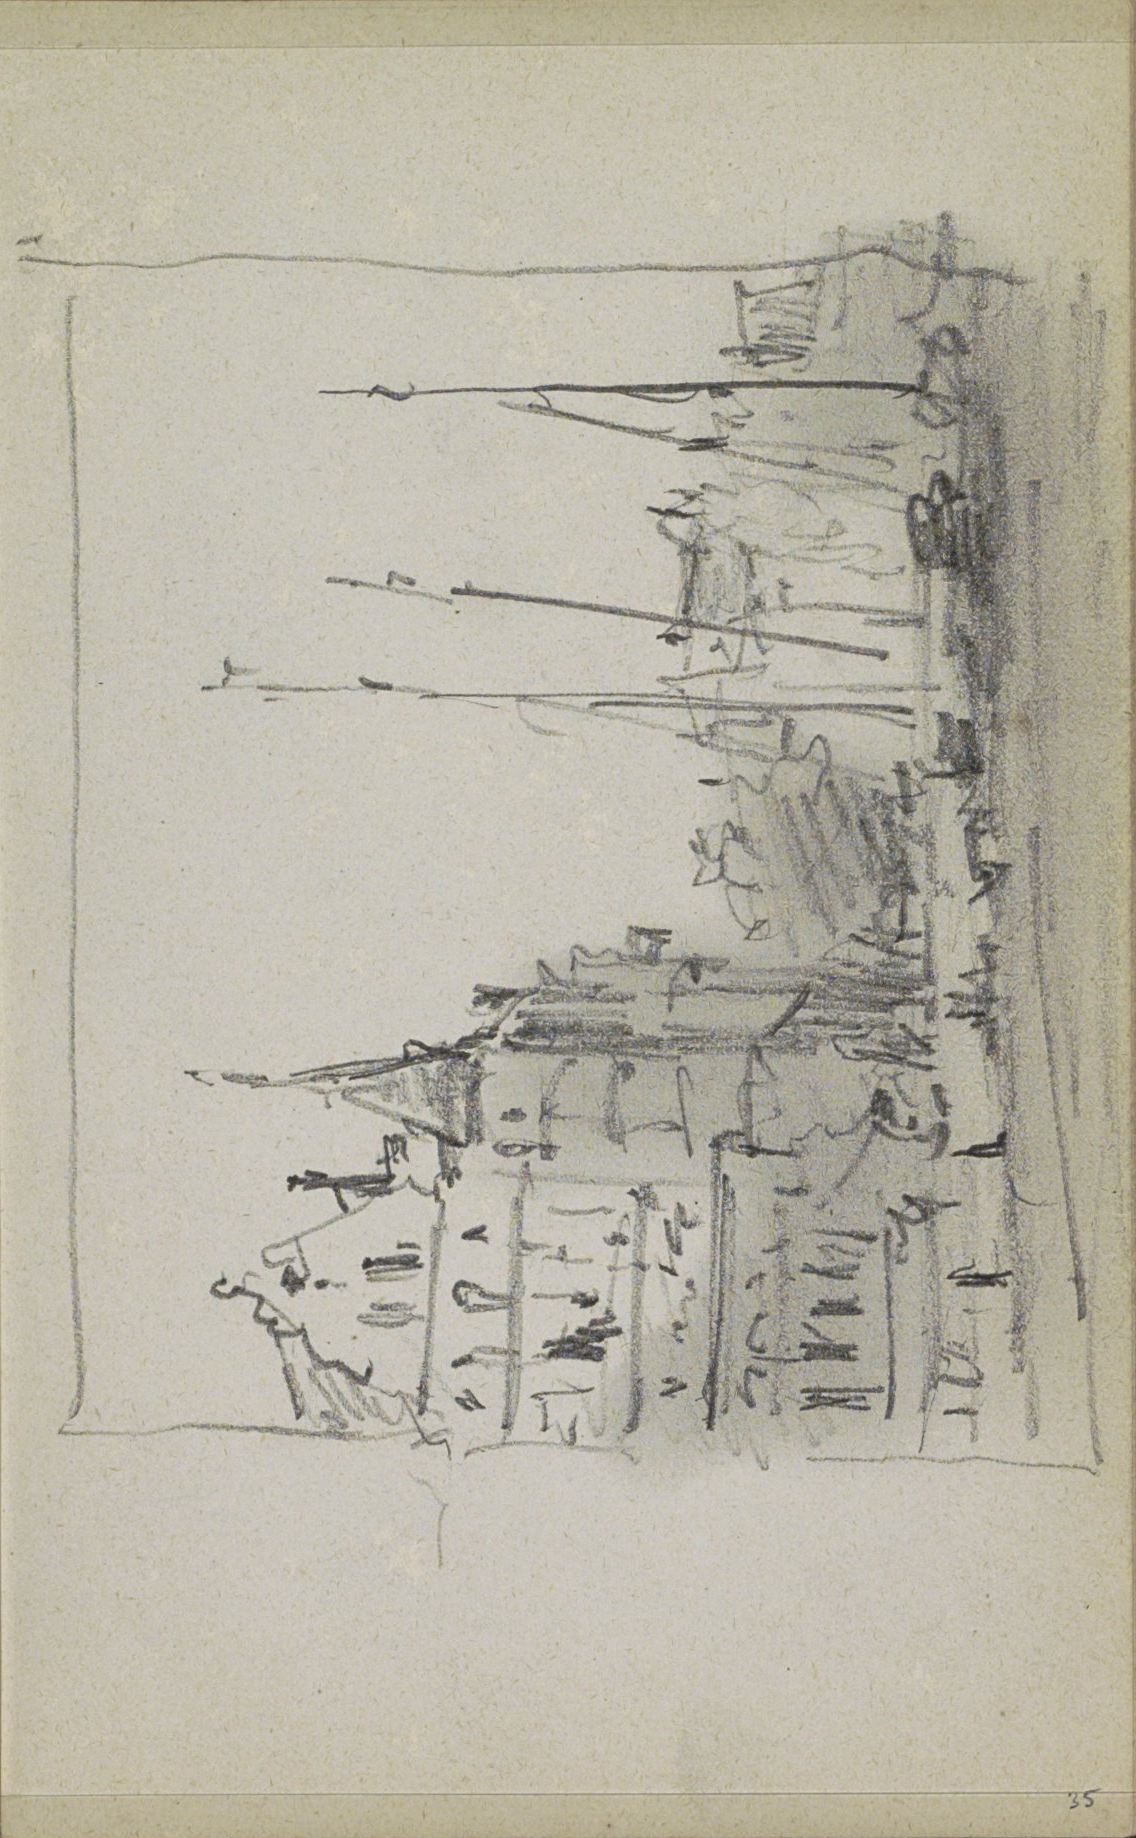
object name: sketchbook leaf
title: Stadsgezicht met zeilschepen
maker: adrianus eversen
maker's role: draughtsman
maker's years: 1818-1897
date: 1828-1897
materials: paper, pencil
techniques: stumping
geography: netherlands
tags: urban housing, city-view, and landscape with man-made constructions, sailing-ship, sailing-boat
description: Stadsgezicht met zeilschepen. Blad 35 recto uit een schetsboek met 58 bladen.